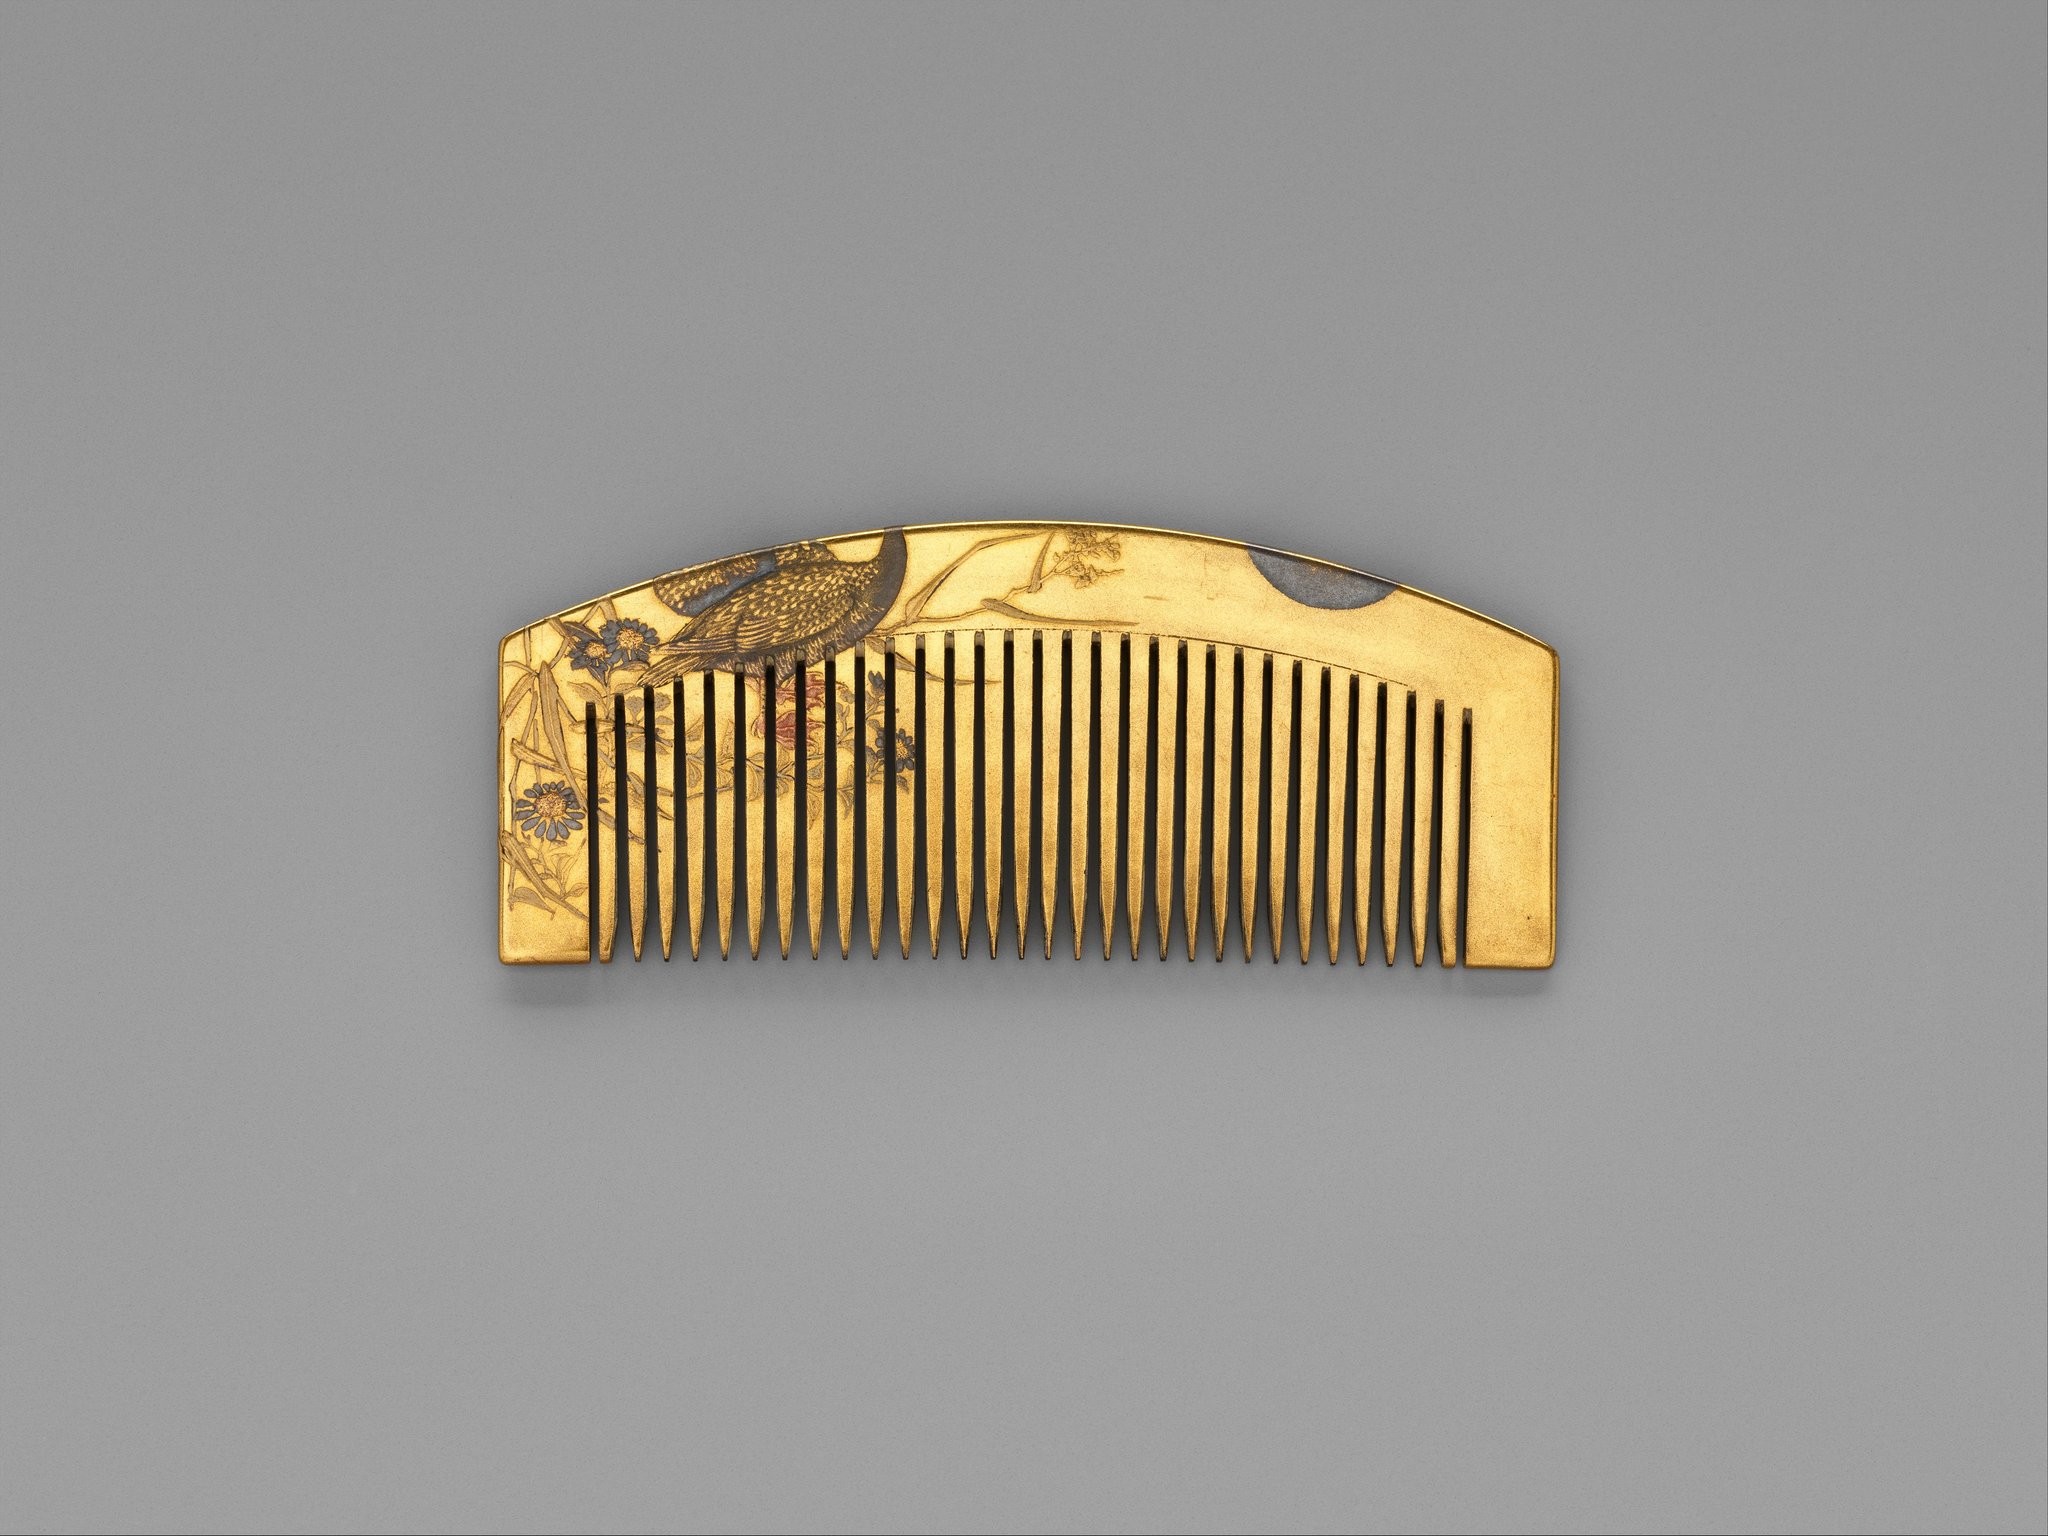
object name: comb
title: Lacquer Comb with Geese and Autumn Grasses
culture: japanese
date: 1851-1900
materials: gold, gold leaf, horn, lacquer, silver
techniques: hiramakie, lacquer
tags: birds,flowers